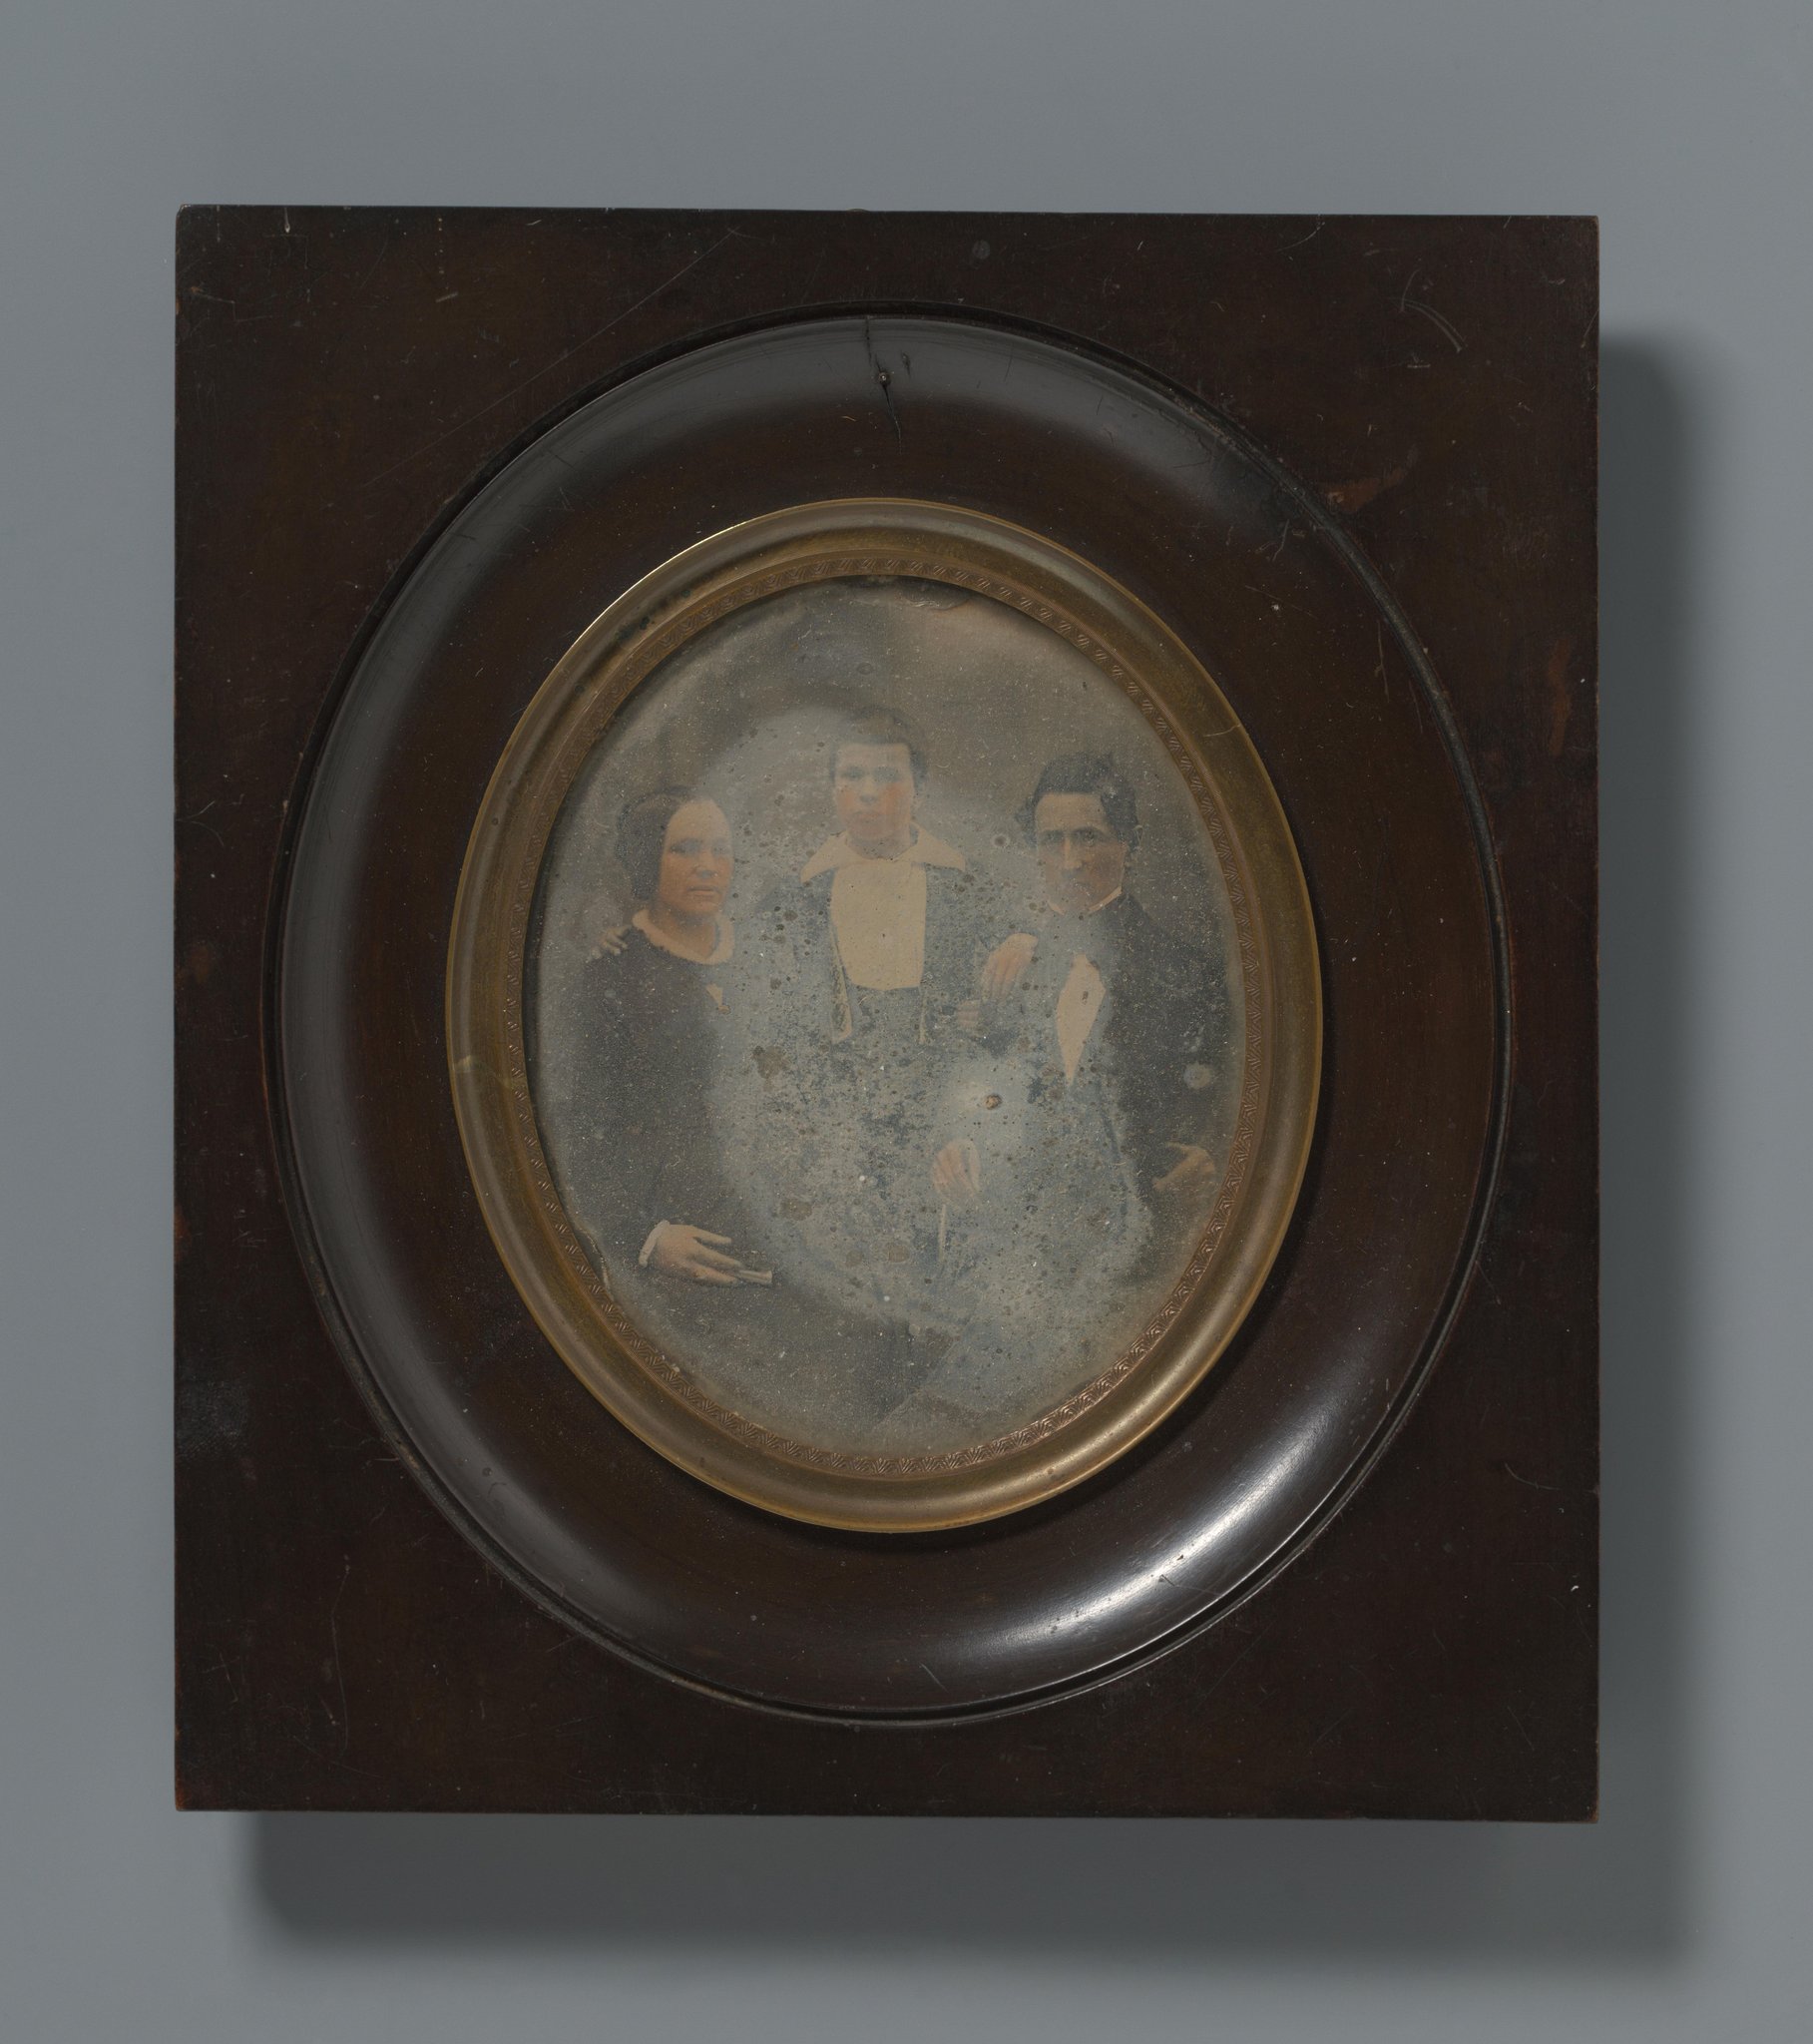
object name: frame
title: Groepsportret van een onbekende man, vrouw en kind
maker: constant dieudonné vauthier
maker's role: fotograaf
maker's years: 1819-1902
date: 1848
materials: copper, glass, metal, paper, silver, wood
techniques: daguerreotype, hand coloring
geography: bern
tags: family group, especially parents with their child(ren), anonymous historical persons portrayed in a group, in a group-portrait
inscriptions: date: ‘1848 20 Septbr’, label: ‘Fait/ par/ Vauthier’